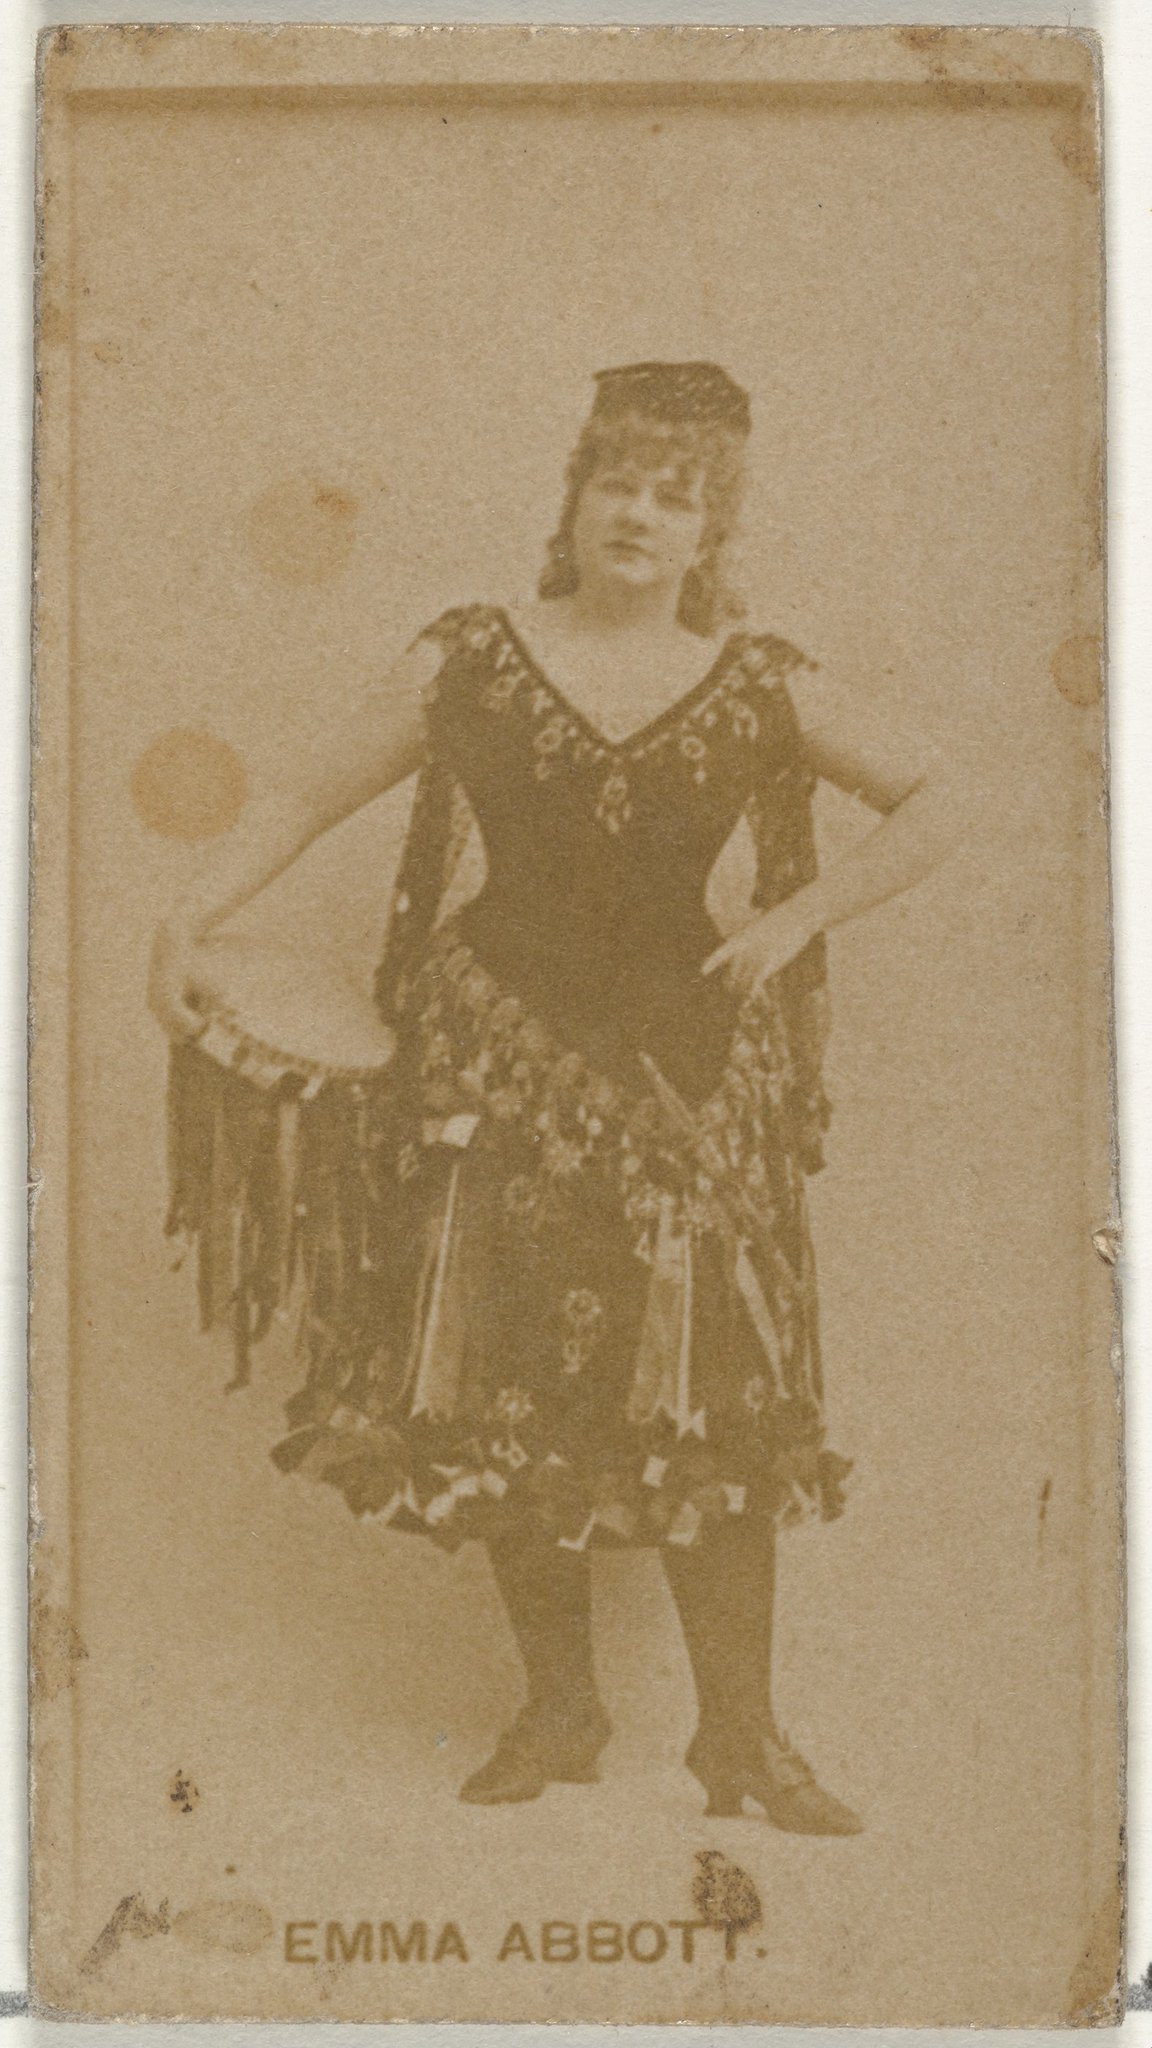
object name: photograph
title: Emma Abbott, from the Actors and Actresses series (N145-8) issued by Duke Sons & Co. to promote Duke Cigarettes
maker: w. duke, sons & co.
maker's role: publisher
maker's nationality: american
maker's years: 1870-1920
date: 1891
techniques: albumen silver print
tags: portraits,women,actresses